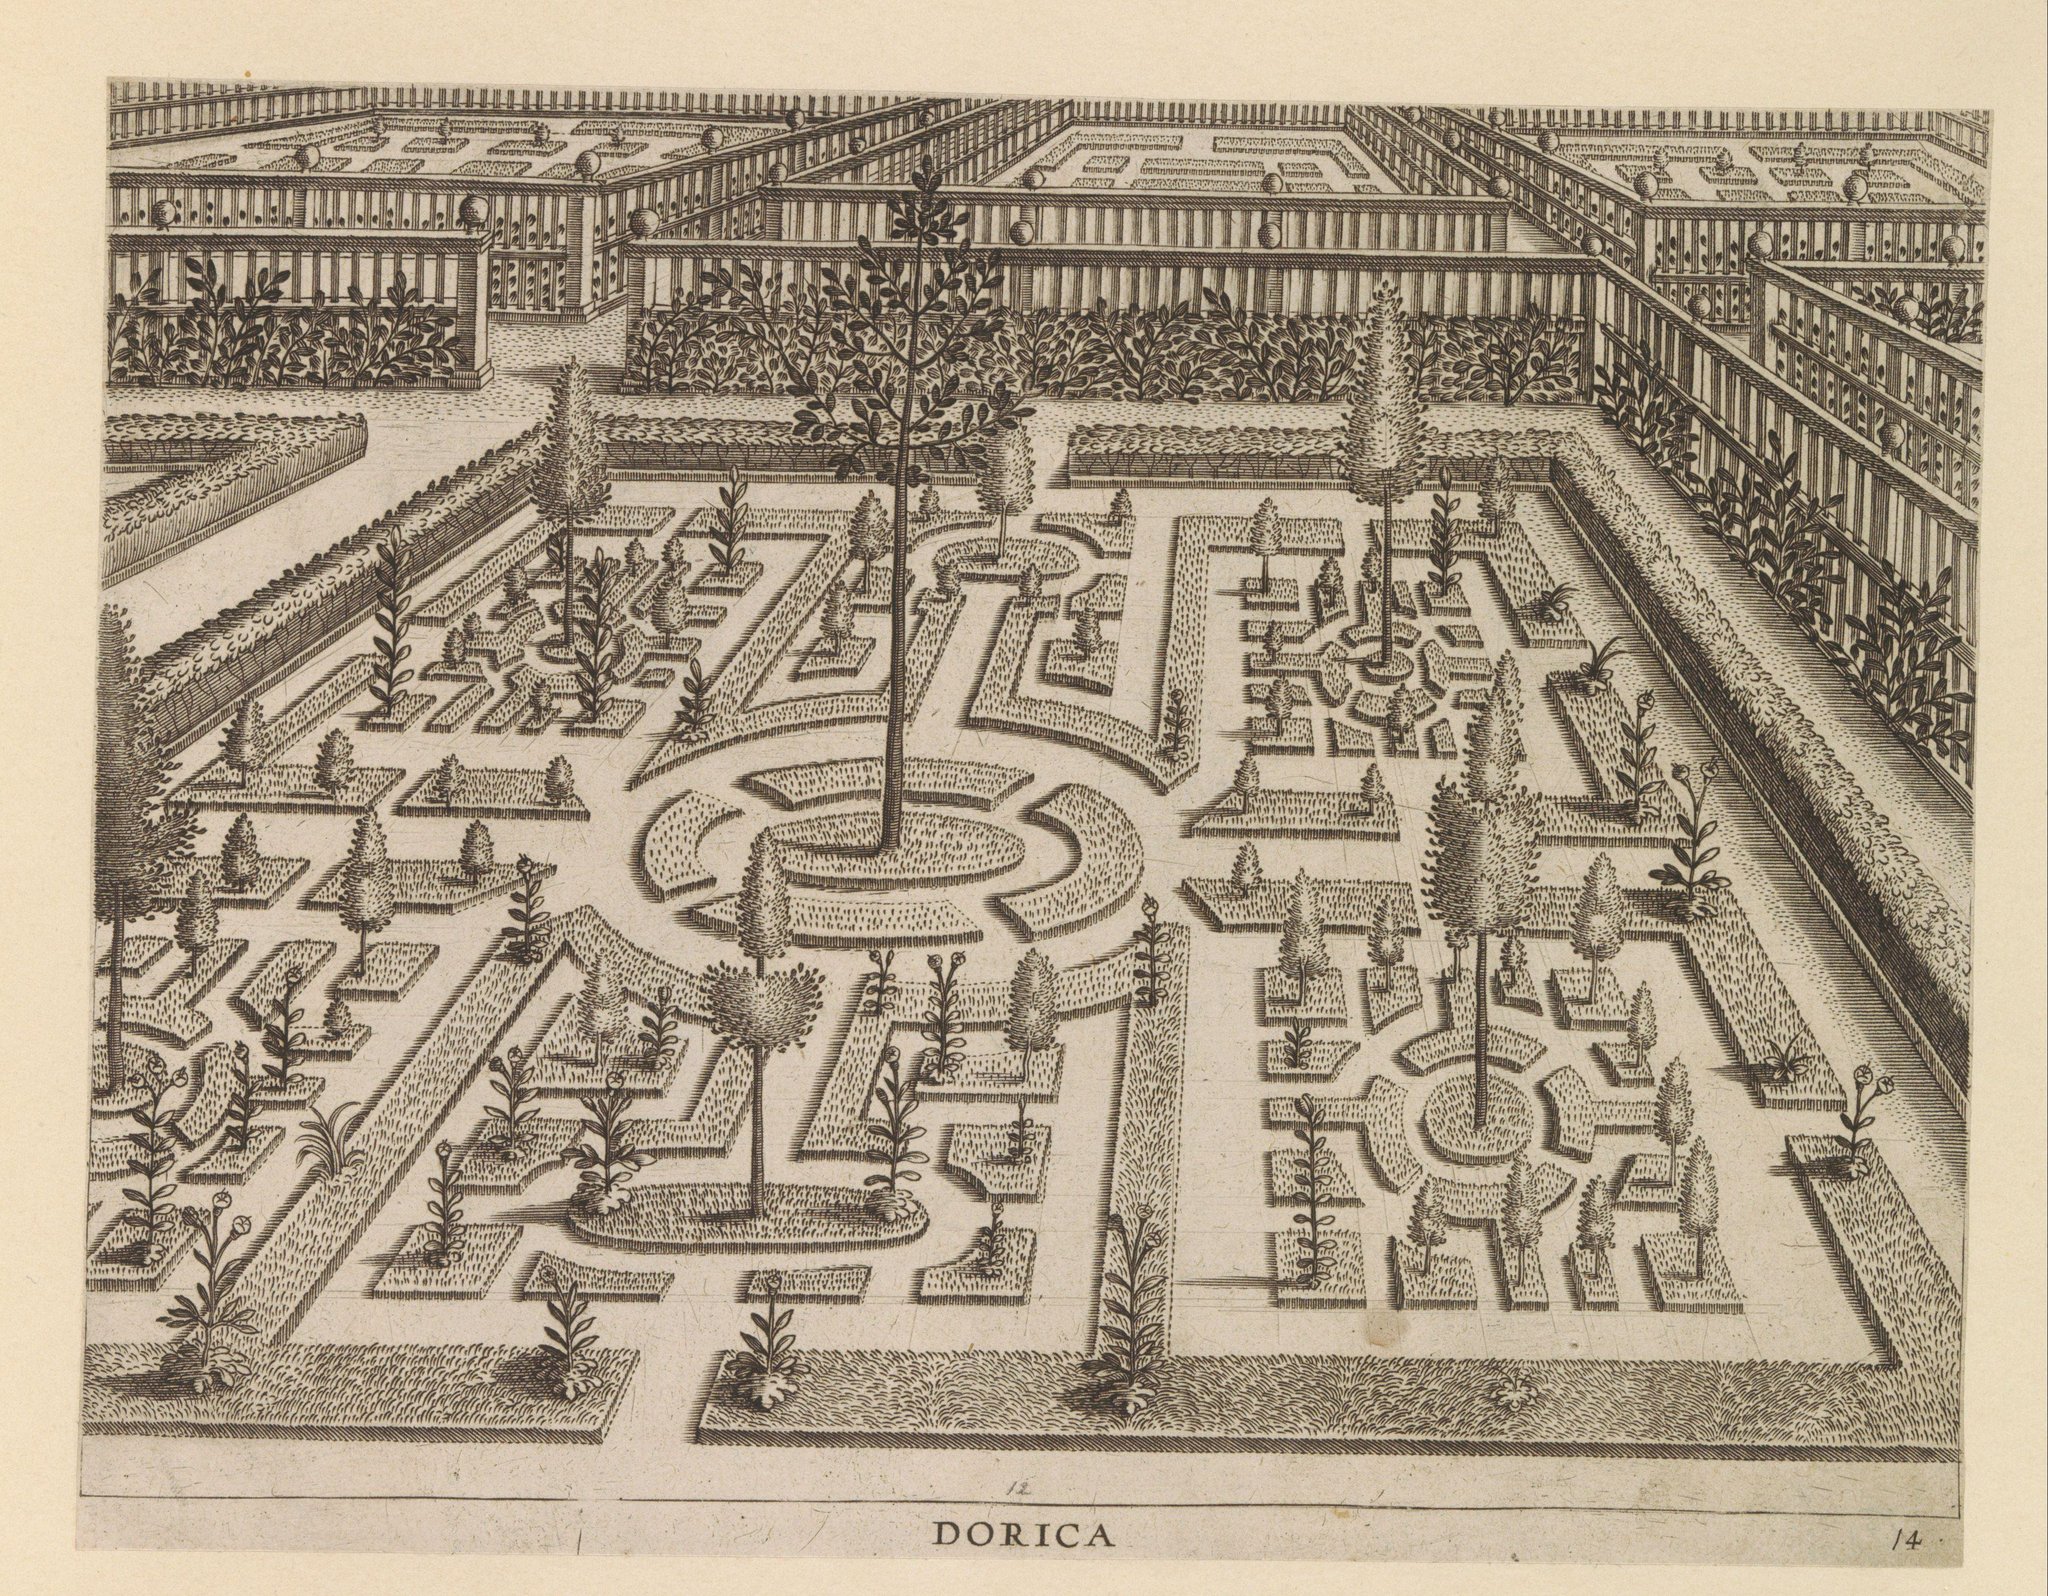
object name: ornament print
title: Tuinontwerpen geassocieerd met de Dorische, Ionische en Korinthische bouworden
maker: Anonymous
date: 1583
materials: paper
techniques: etching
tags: garden, french or architectonic garden; formal garden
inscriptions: inscription: ‘1’, inscription: ‘12’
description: Tuin met centrale parterre bestaande uit zes compartimenten rond een boom in het centrum. De tuin is aangelegd volgens de Dorische bouworde. De prent maakt deel uit van een album.